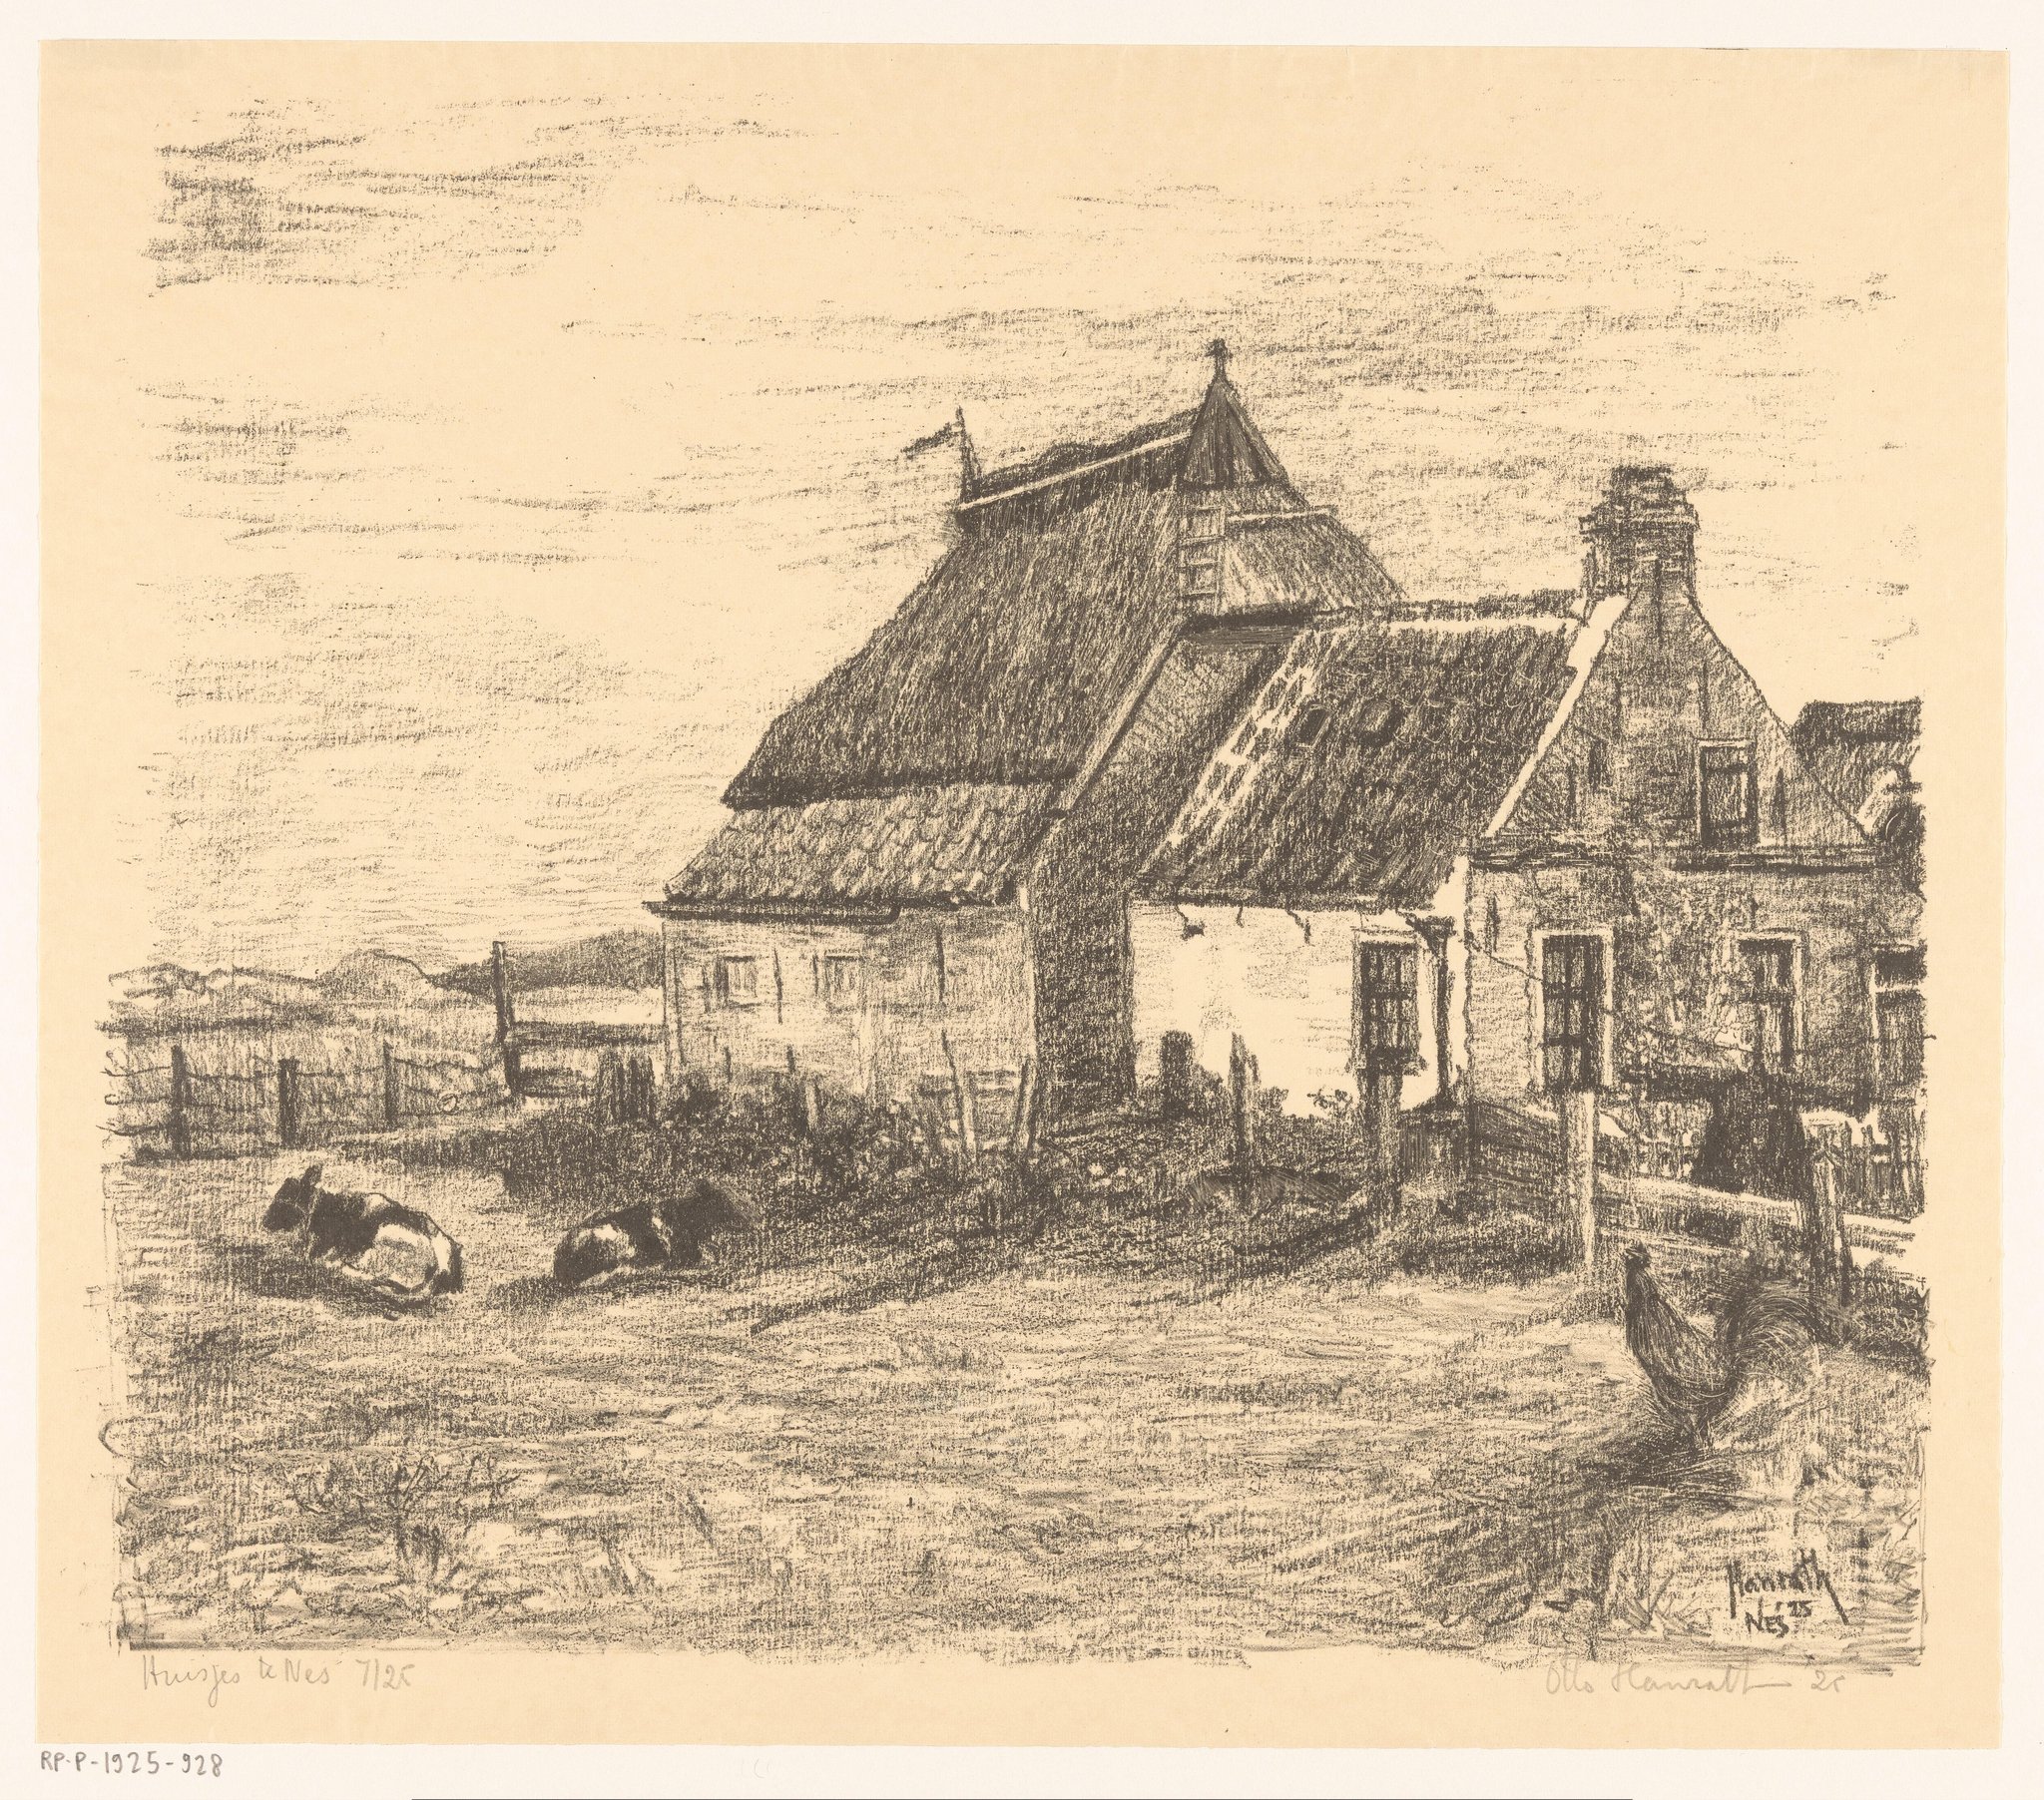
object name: print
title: Huisjes te Nes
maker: otto hanrath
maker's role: print maker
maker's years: 1882-1944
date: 1925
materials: paper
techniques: lithograph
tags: cow, fowl (cock, hen, chicken, etc.), farm or solitary house in landscape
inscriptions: collector's mark: Lugt 2228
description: Op de voorgrond een weiland met twee kalveren en een haan. Naast het weiland een boerderij met schuur. Op de achtergrond duinen.